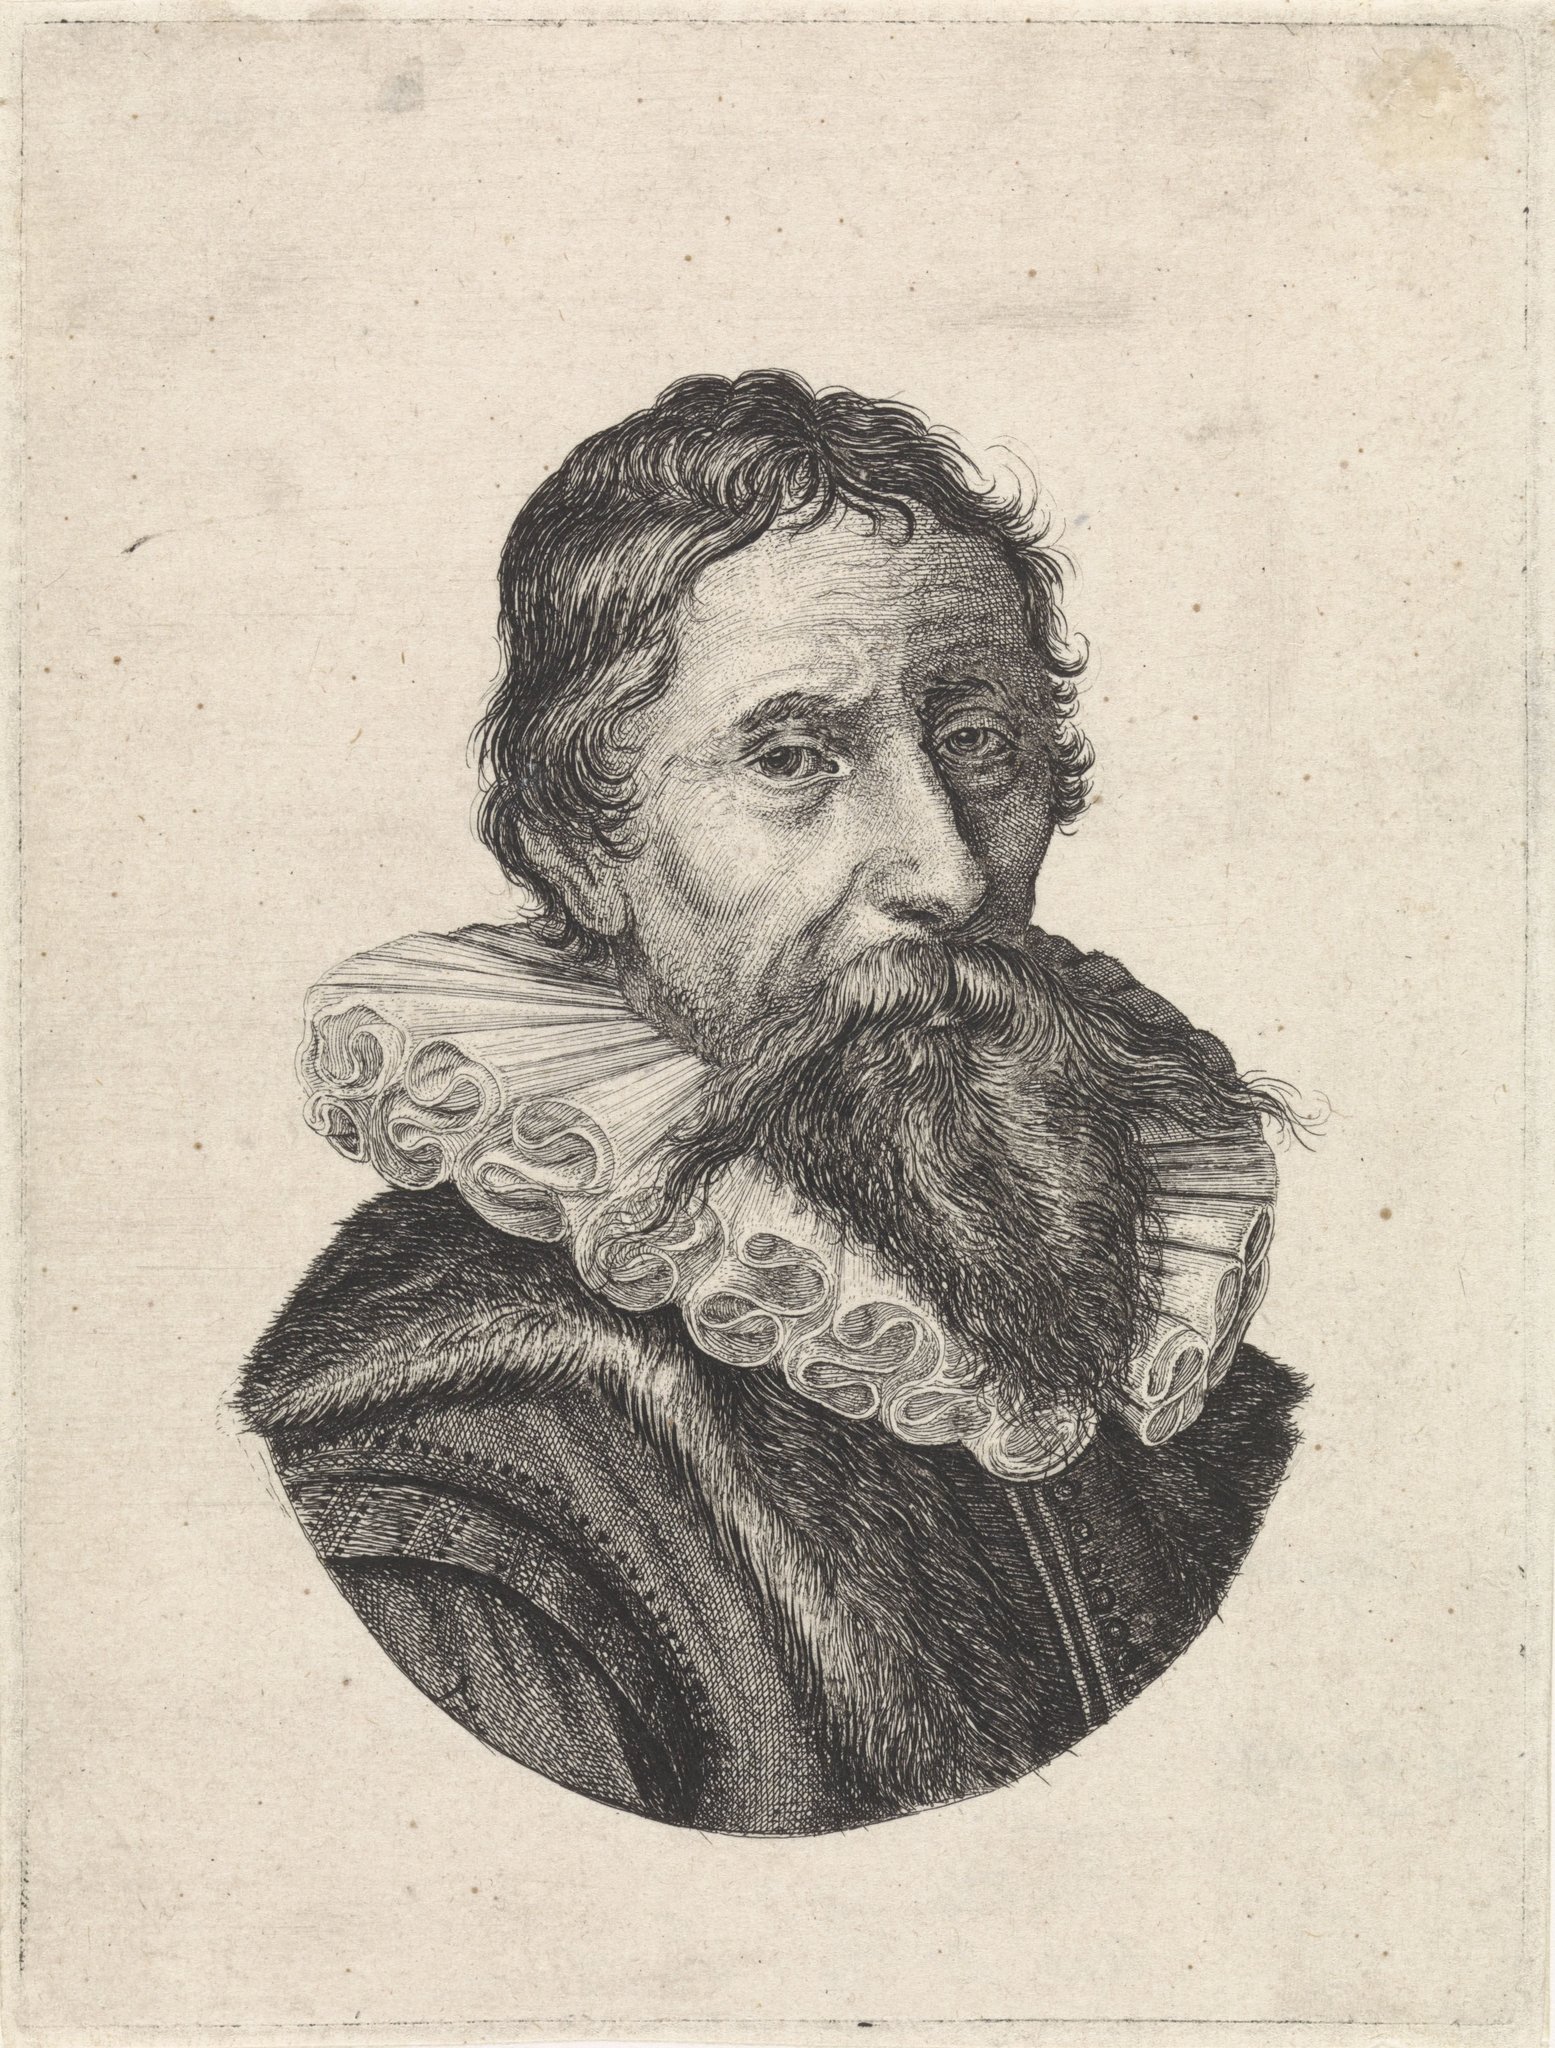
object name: print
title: Portret van Johan Fonteyn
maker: Anonymous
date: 1626-1678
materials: paper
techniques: engraving, etching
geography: netherlands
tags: johan fonteyn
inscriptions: collector's mark: Lugt 2228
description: Portret van Johan Fonteyn, arts te Amsterdam.